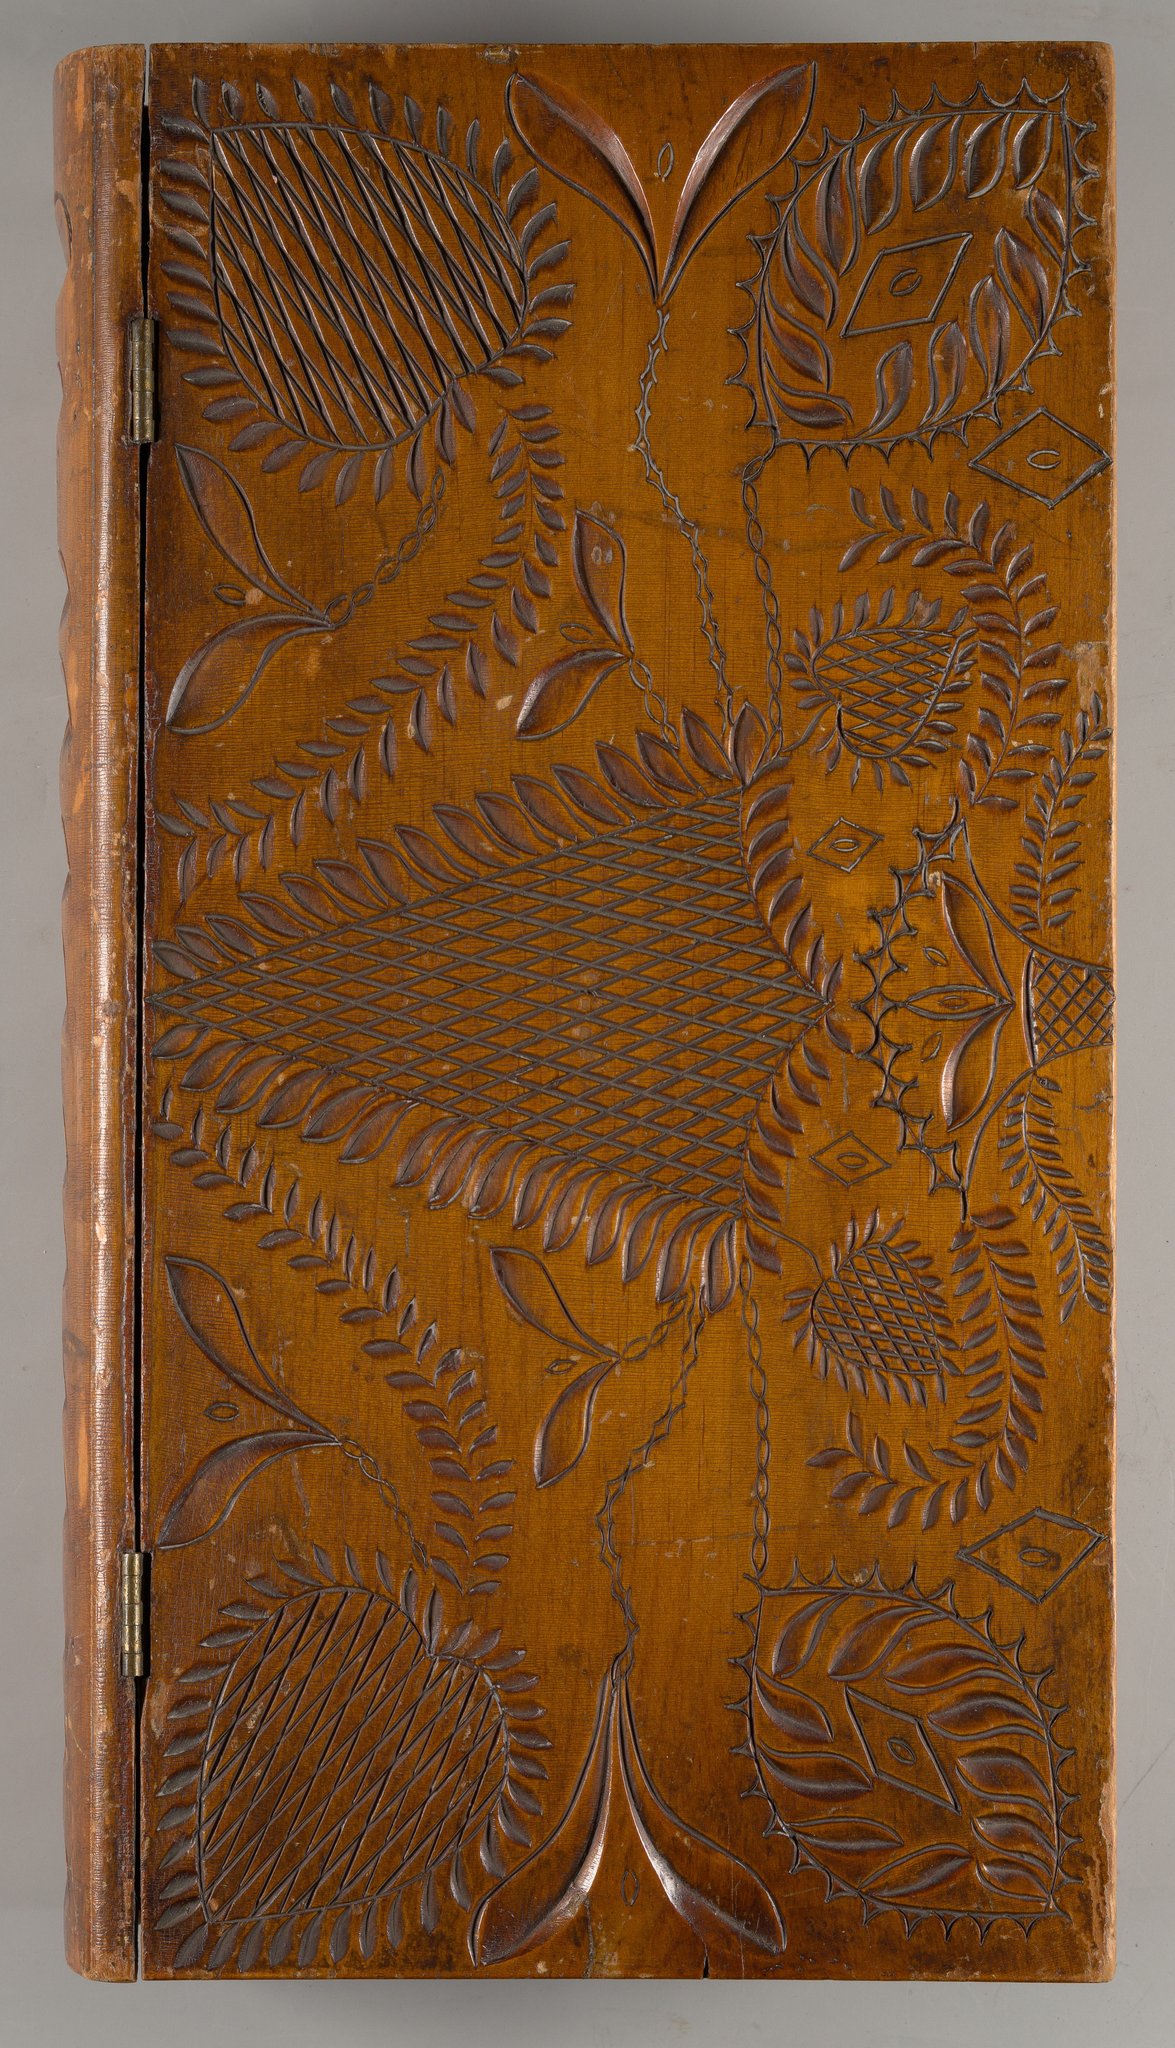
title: Box in the form of a book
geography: united states